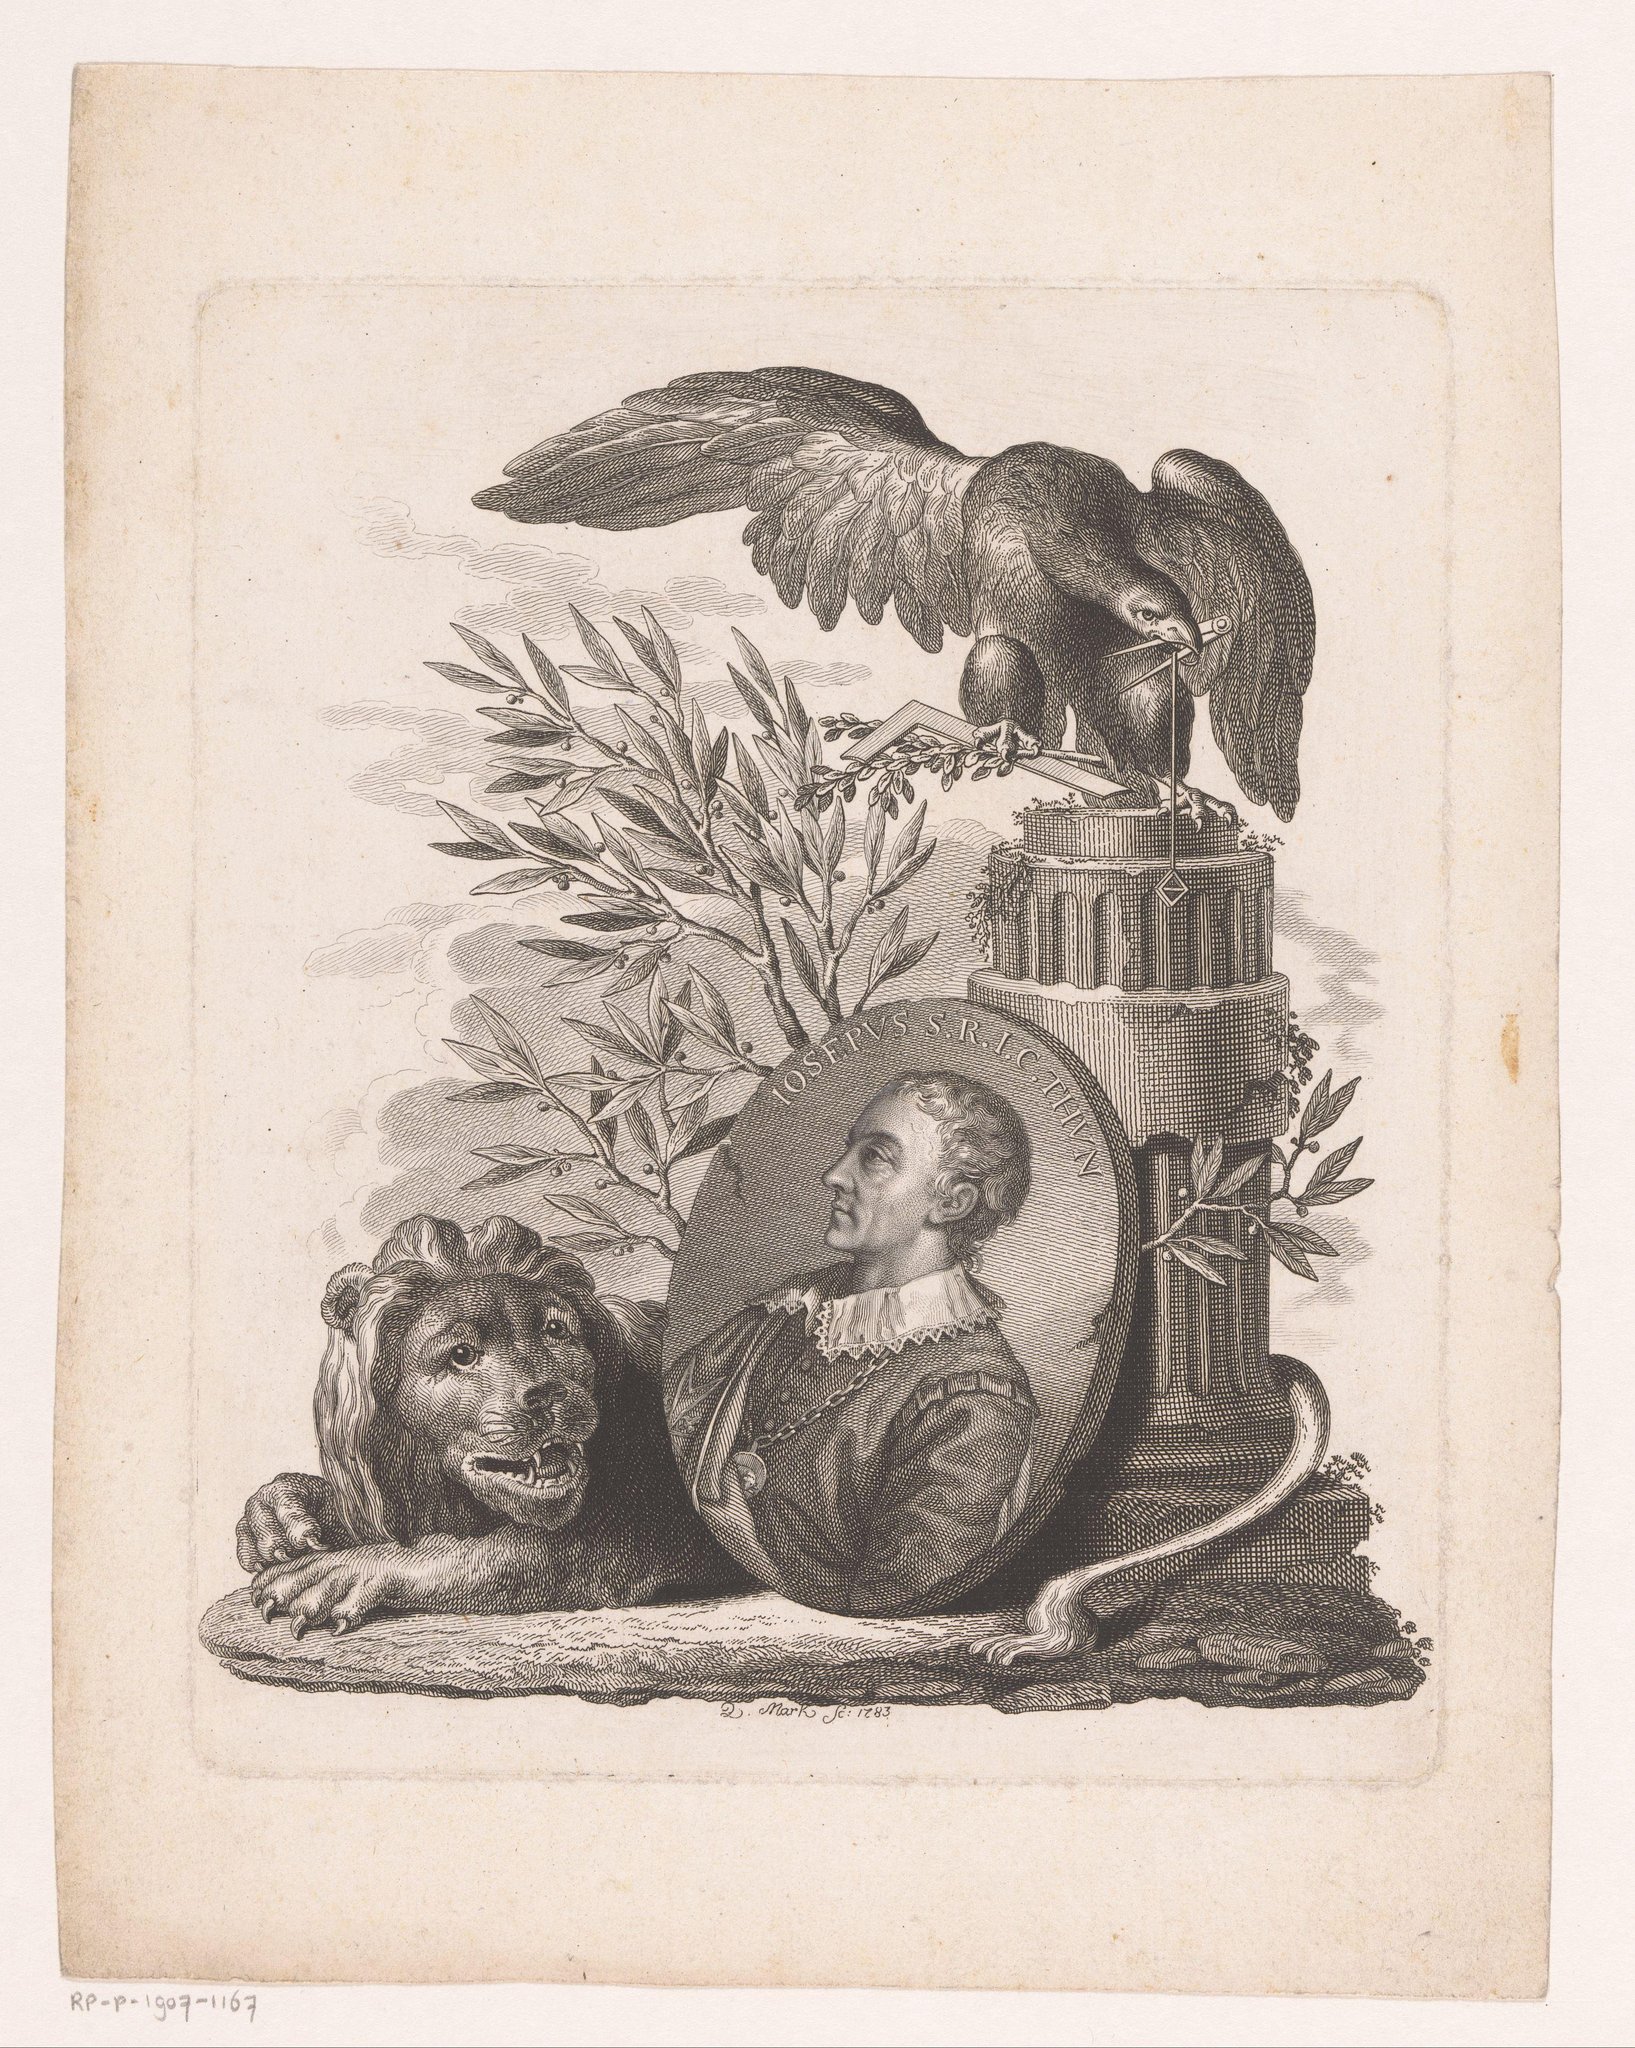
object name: print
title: Portret van Franz Joseph von Thun met adelaar en leeuw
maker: quirin mark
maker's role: print maker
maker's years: 1753-1811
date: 1783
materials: paper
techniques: engraving, etching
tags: predatory birds: eagle, historical persons, beasts of prey, predatory animals: lion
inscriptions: collector's mark: Lugt 2228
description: Een stenen tablet met het portret van Franz Joseph von Thun. Daarbij ligt een leeuw. Op een halve zuil, waar tegen een lauriertak staat, zit een adelaar met een passer, rechthoek en paslood.